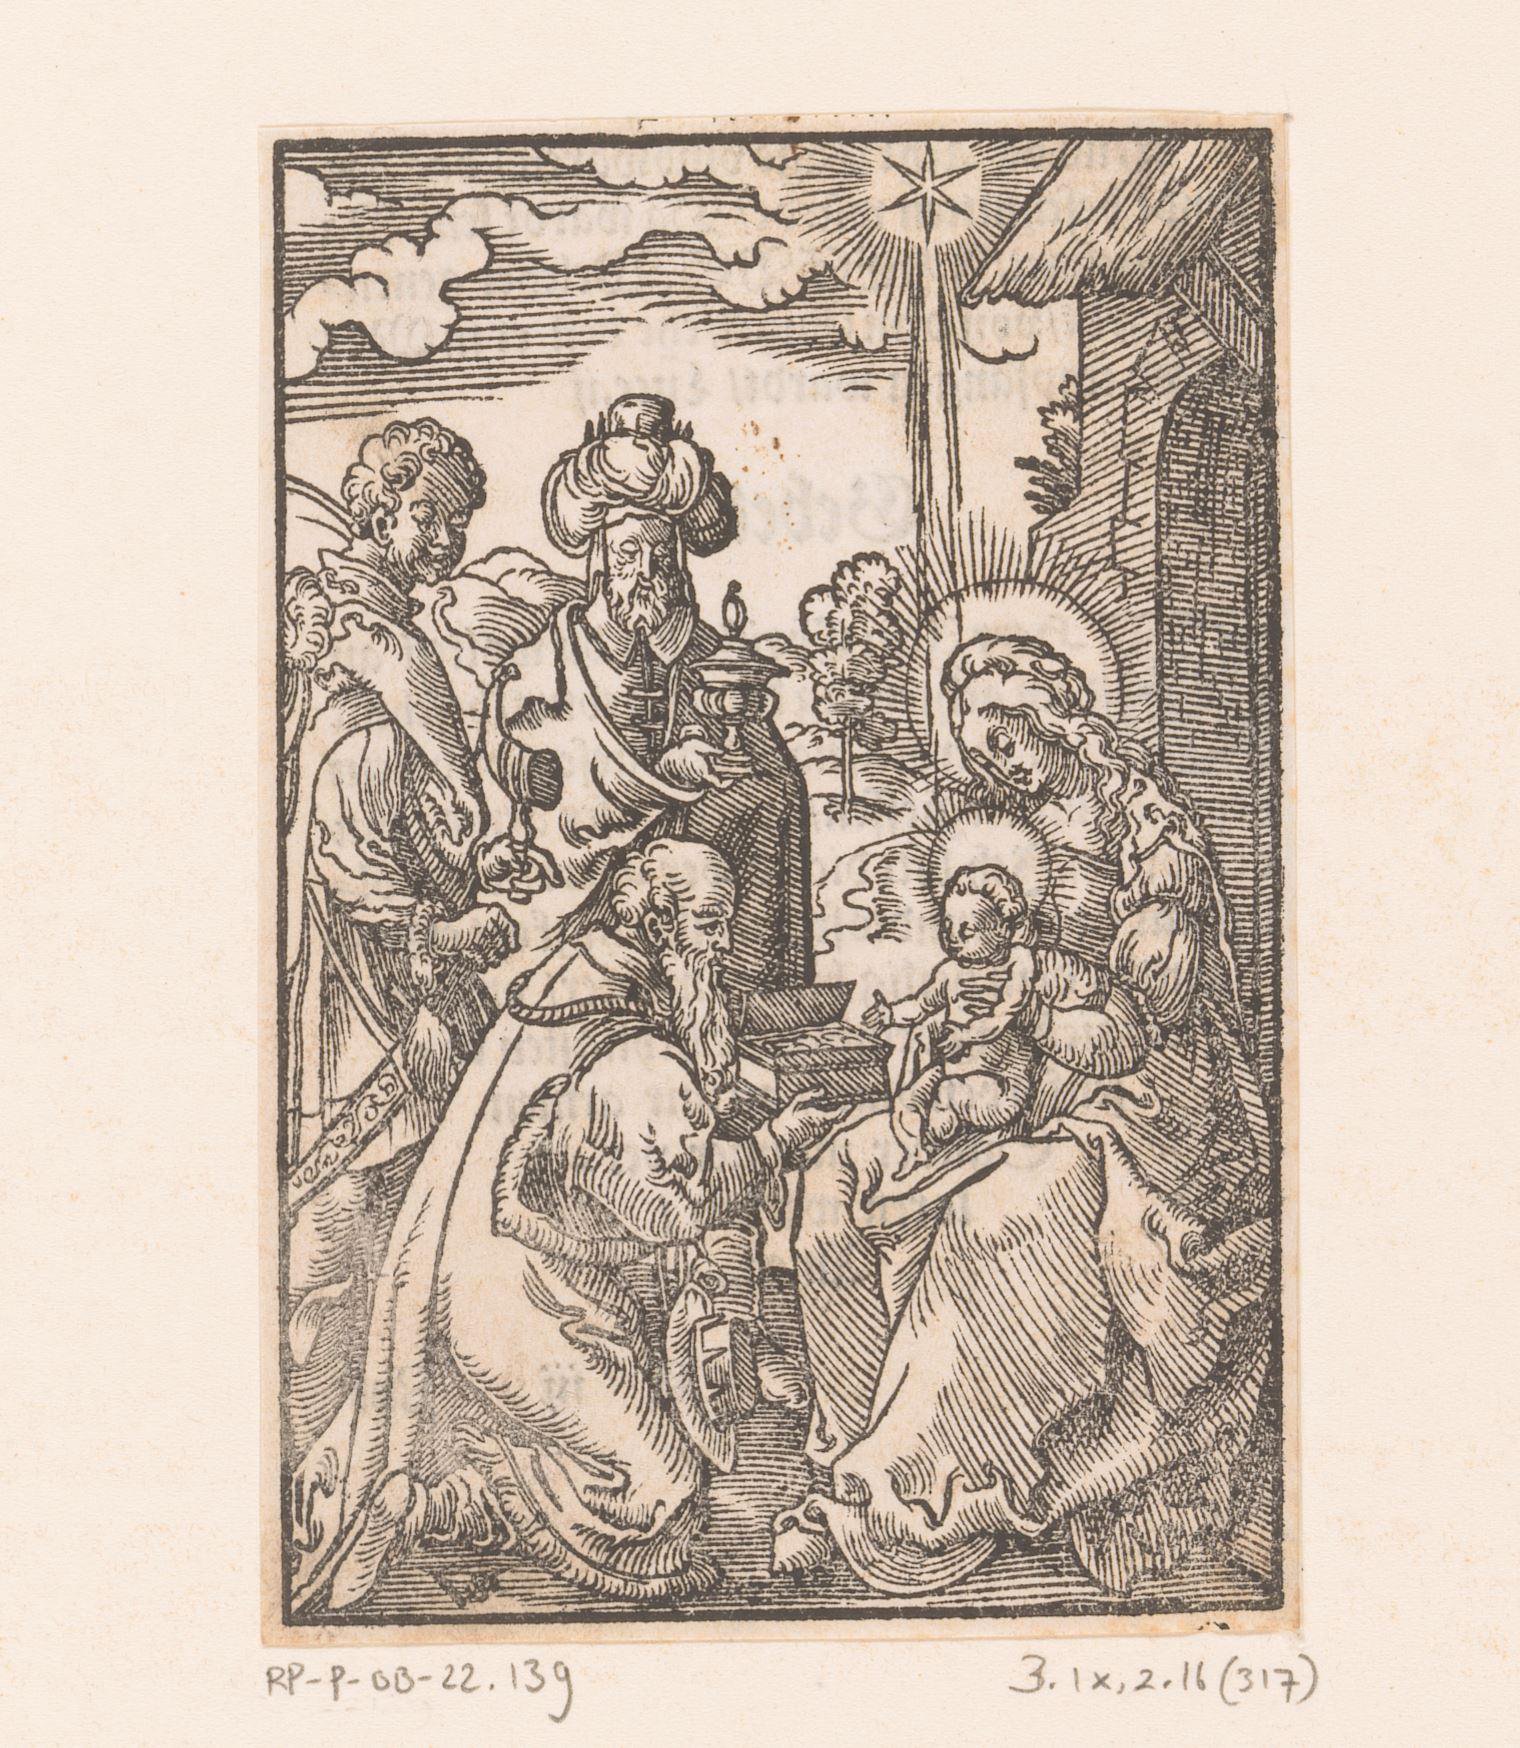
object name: book illustration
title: Aanbidding door de koningen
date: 1552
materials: paper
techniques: woodcut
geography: nuremberg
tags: adoration of the kings: the wise men present their gifts to the christ-child (gold, frankincense and myrrh)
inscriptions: number: ‘181’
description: Gebruikt voor verschillende publicaties die werden gedrukt door Valentin Geißler tussen 1552 en 1560 te Neurenberg.